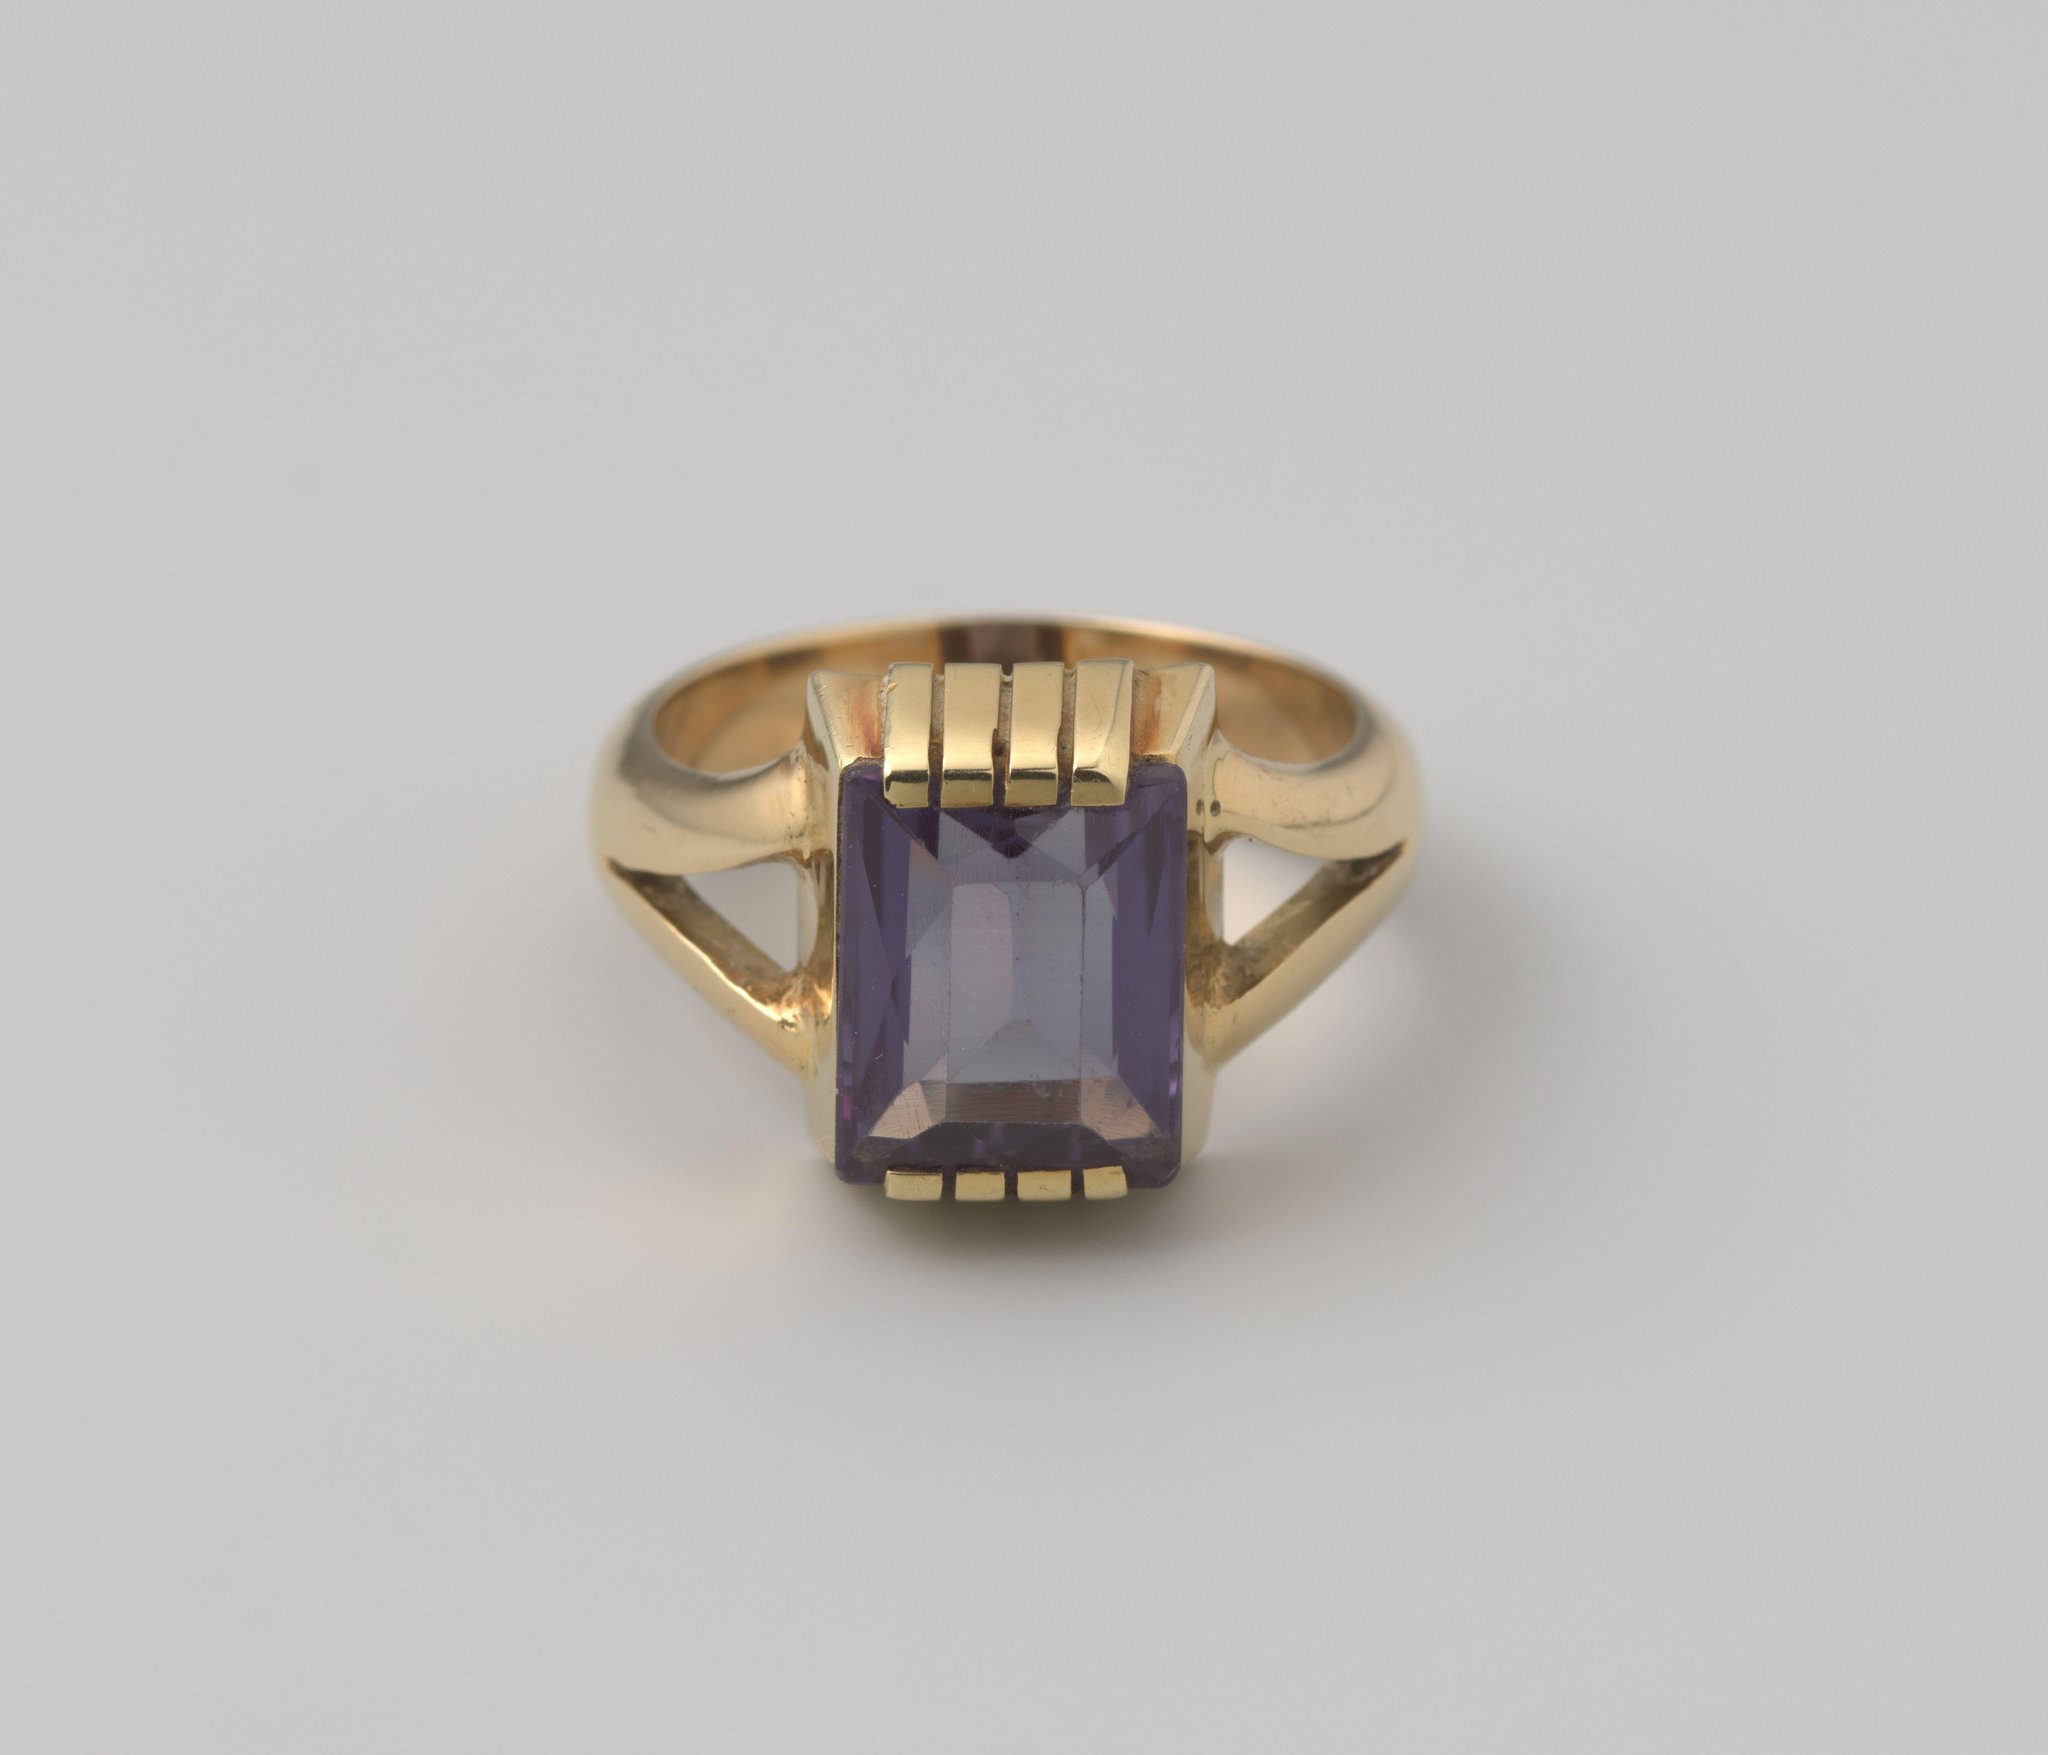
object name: ring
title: Hergebruikte trouwring met synthetische spinel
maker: Anonymous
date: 1940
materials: gold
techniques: sawing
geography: netherlands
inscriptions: import mark: ‘585’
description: Hergebruikte trouwring met emeraud geslepen paarsgroene synthetische spinel (imitatie alexandriet). De trouwring van goud is opengezaagd, deels gesplitst en daartussen is een spinel geplaatst.